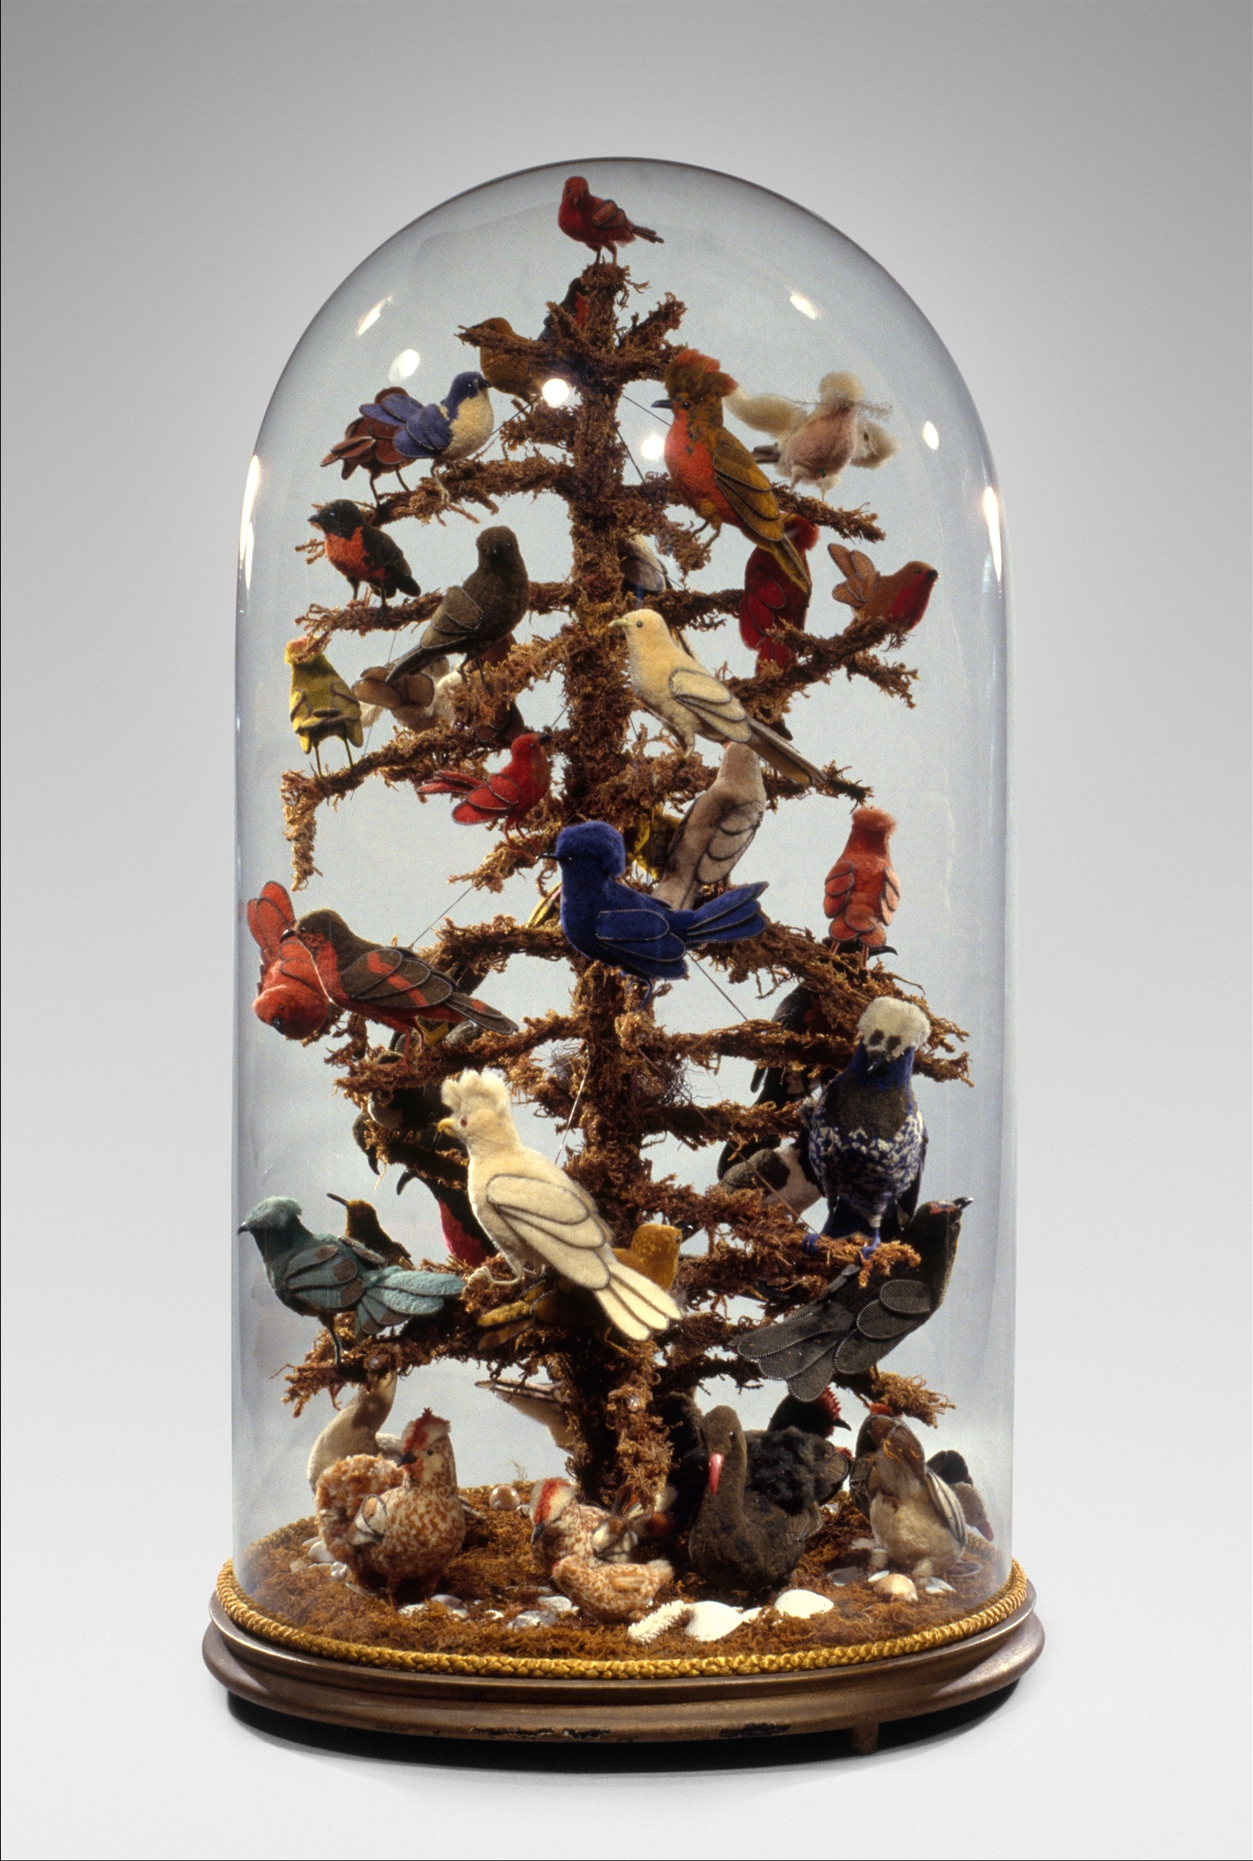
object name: aviary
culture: american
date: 1850-1860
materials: brass, glass, wool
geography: united states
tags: birds,plants